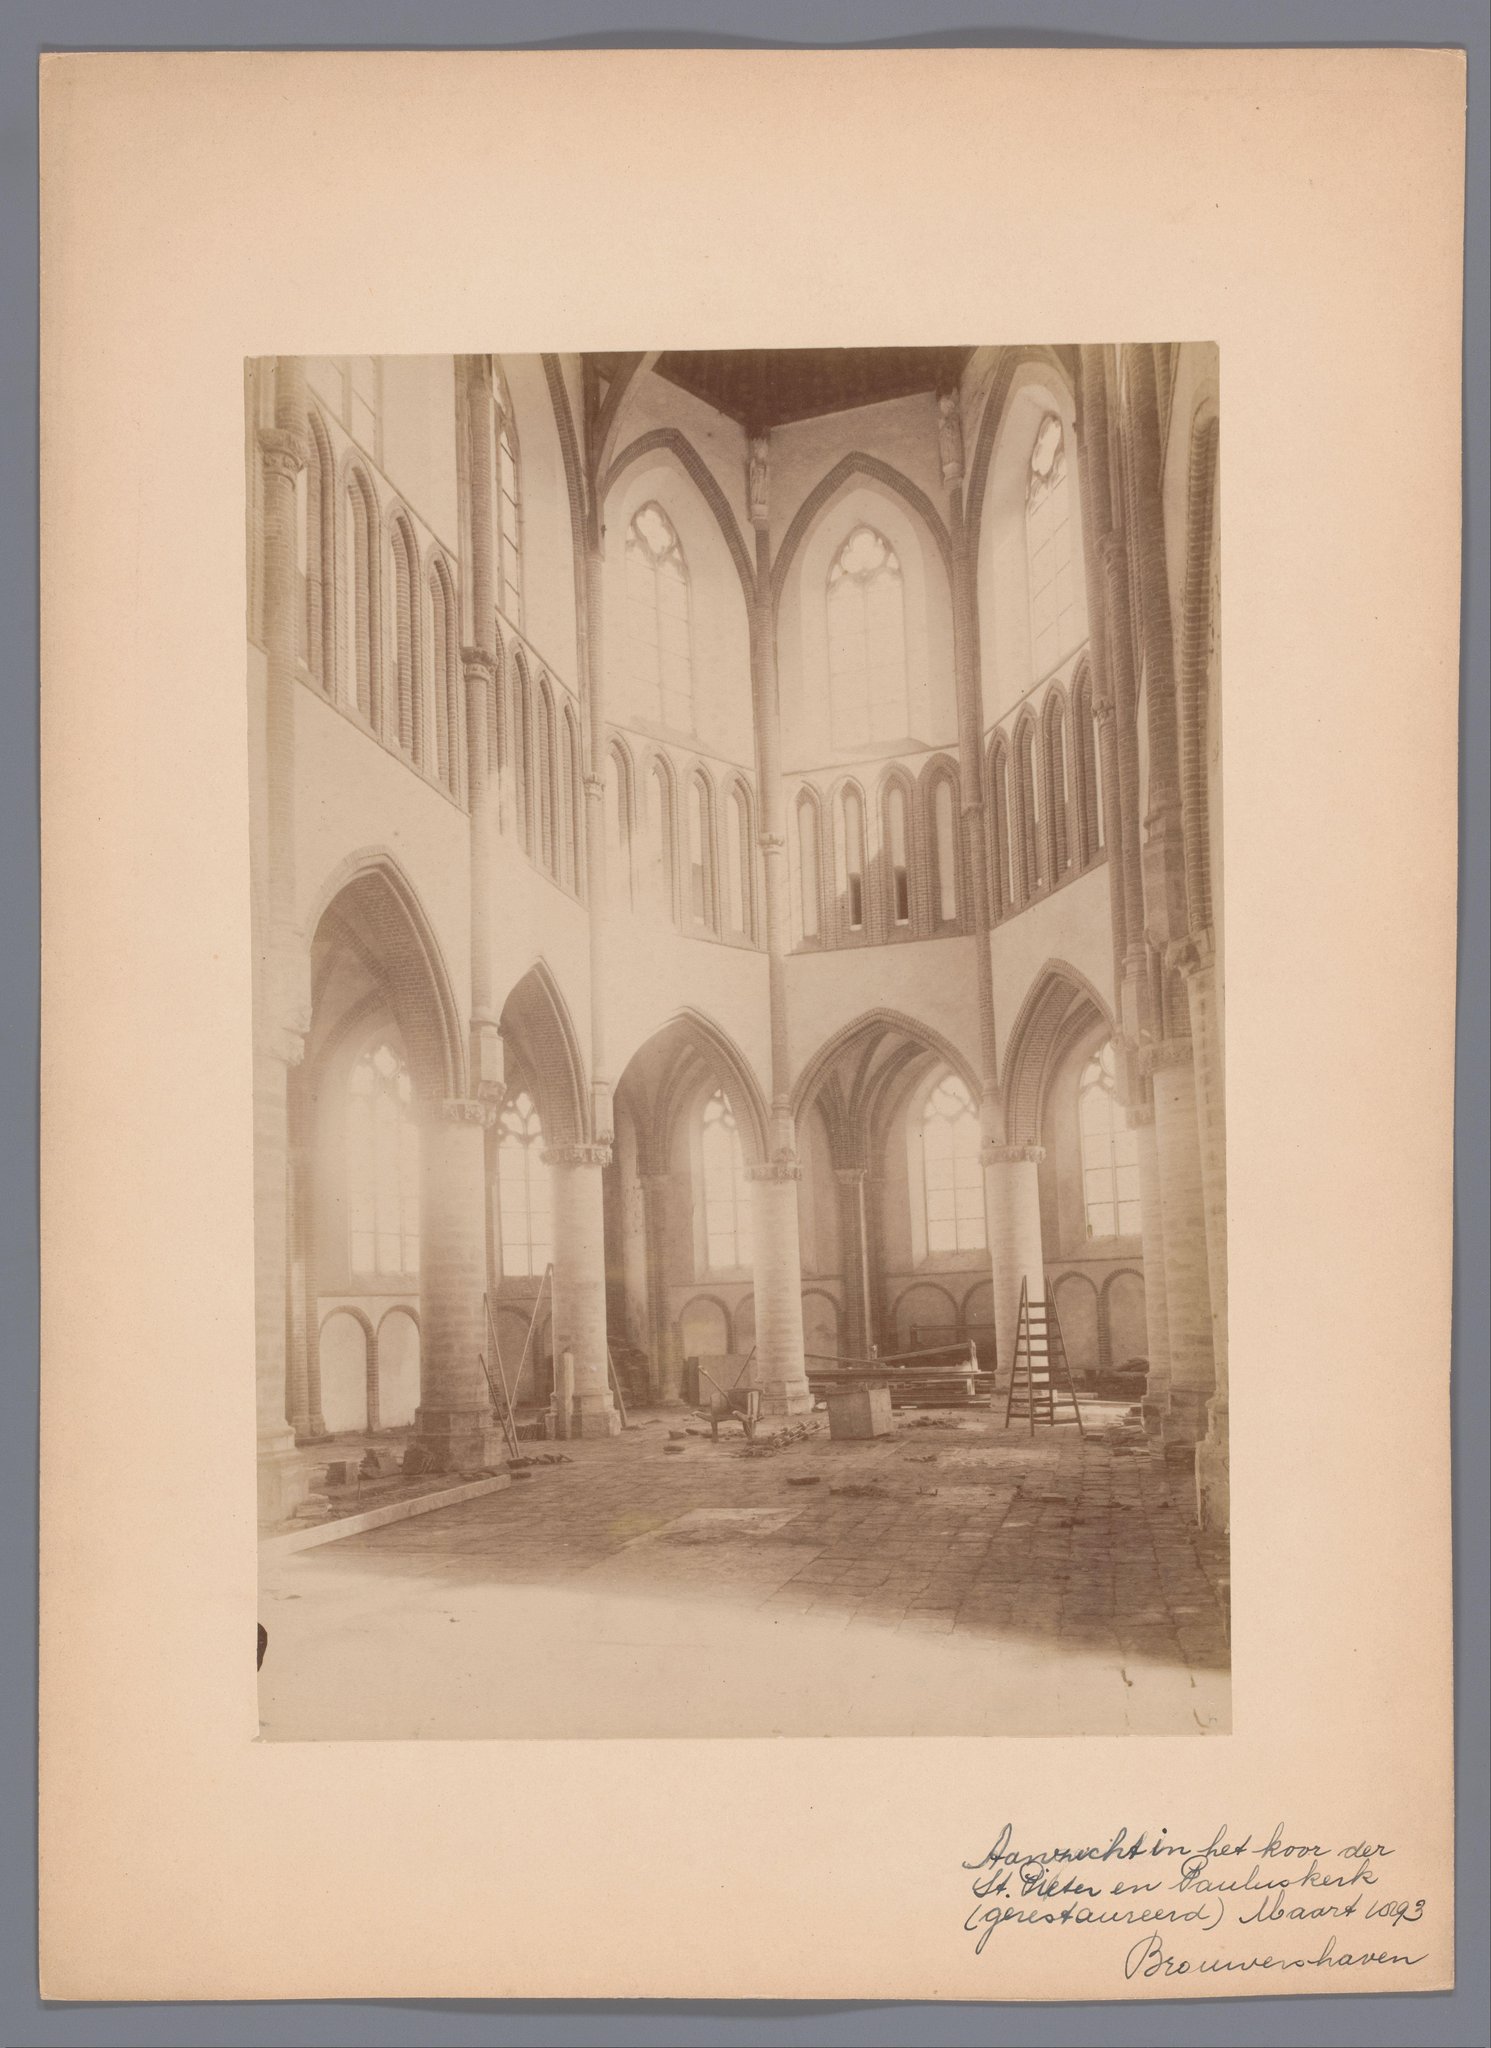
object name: photograph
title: Interieur van de Grote of Sint Nicolaaskerk te Brouwershaven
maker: anoniem (monumentenzorg)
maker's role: fotograaf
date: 1893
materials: cardboard, photographic support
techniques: albumen print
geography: brouwershaven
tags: parts of church interior: choir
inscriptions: annotation: ‘Aanzicht in het koor der St. Pieter en Pauluskerk (gerestaureerd) Maart 1893/ Brouwershaven’, annotation: ‘Aangezicht in het Koor der St. Pieter & Pauluskerk/ (gerestaureerd)/ Maart 1893’